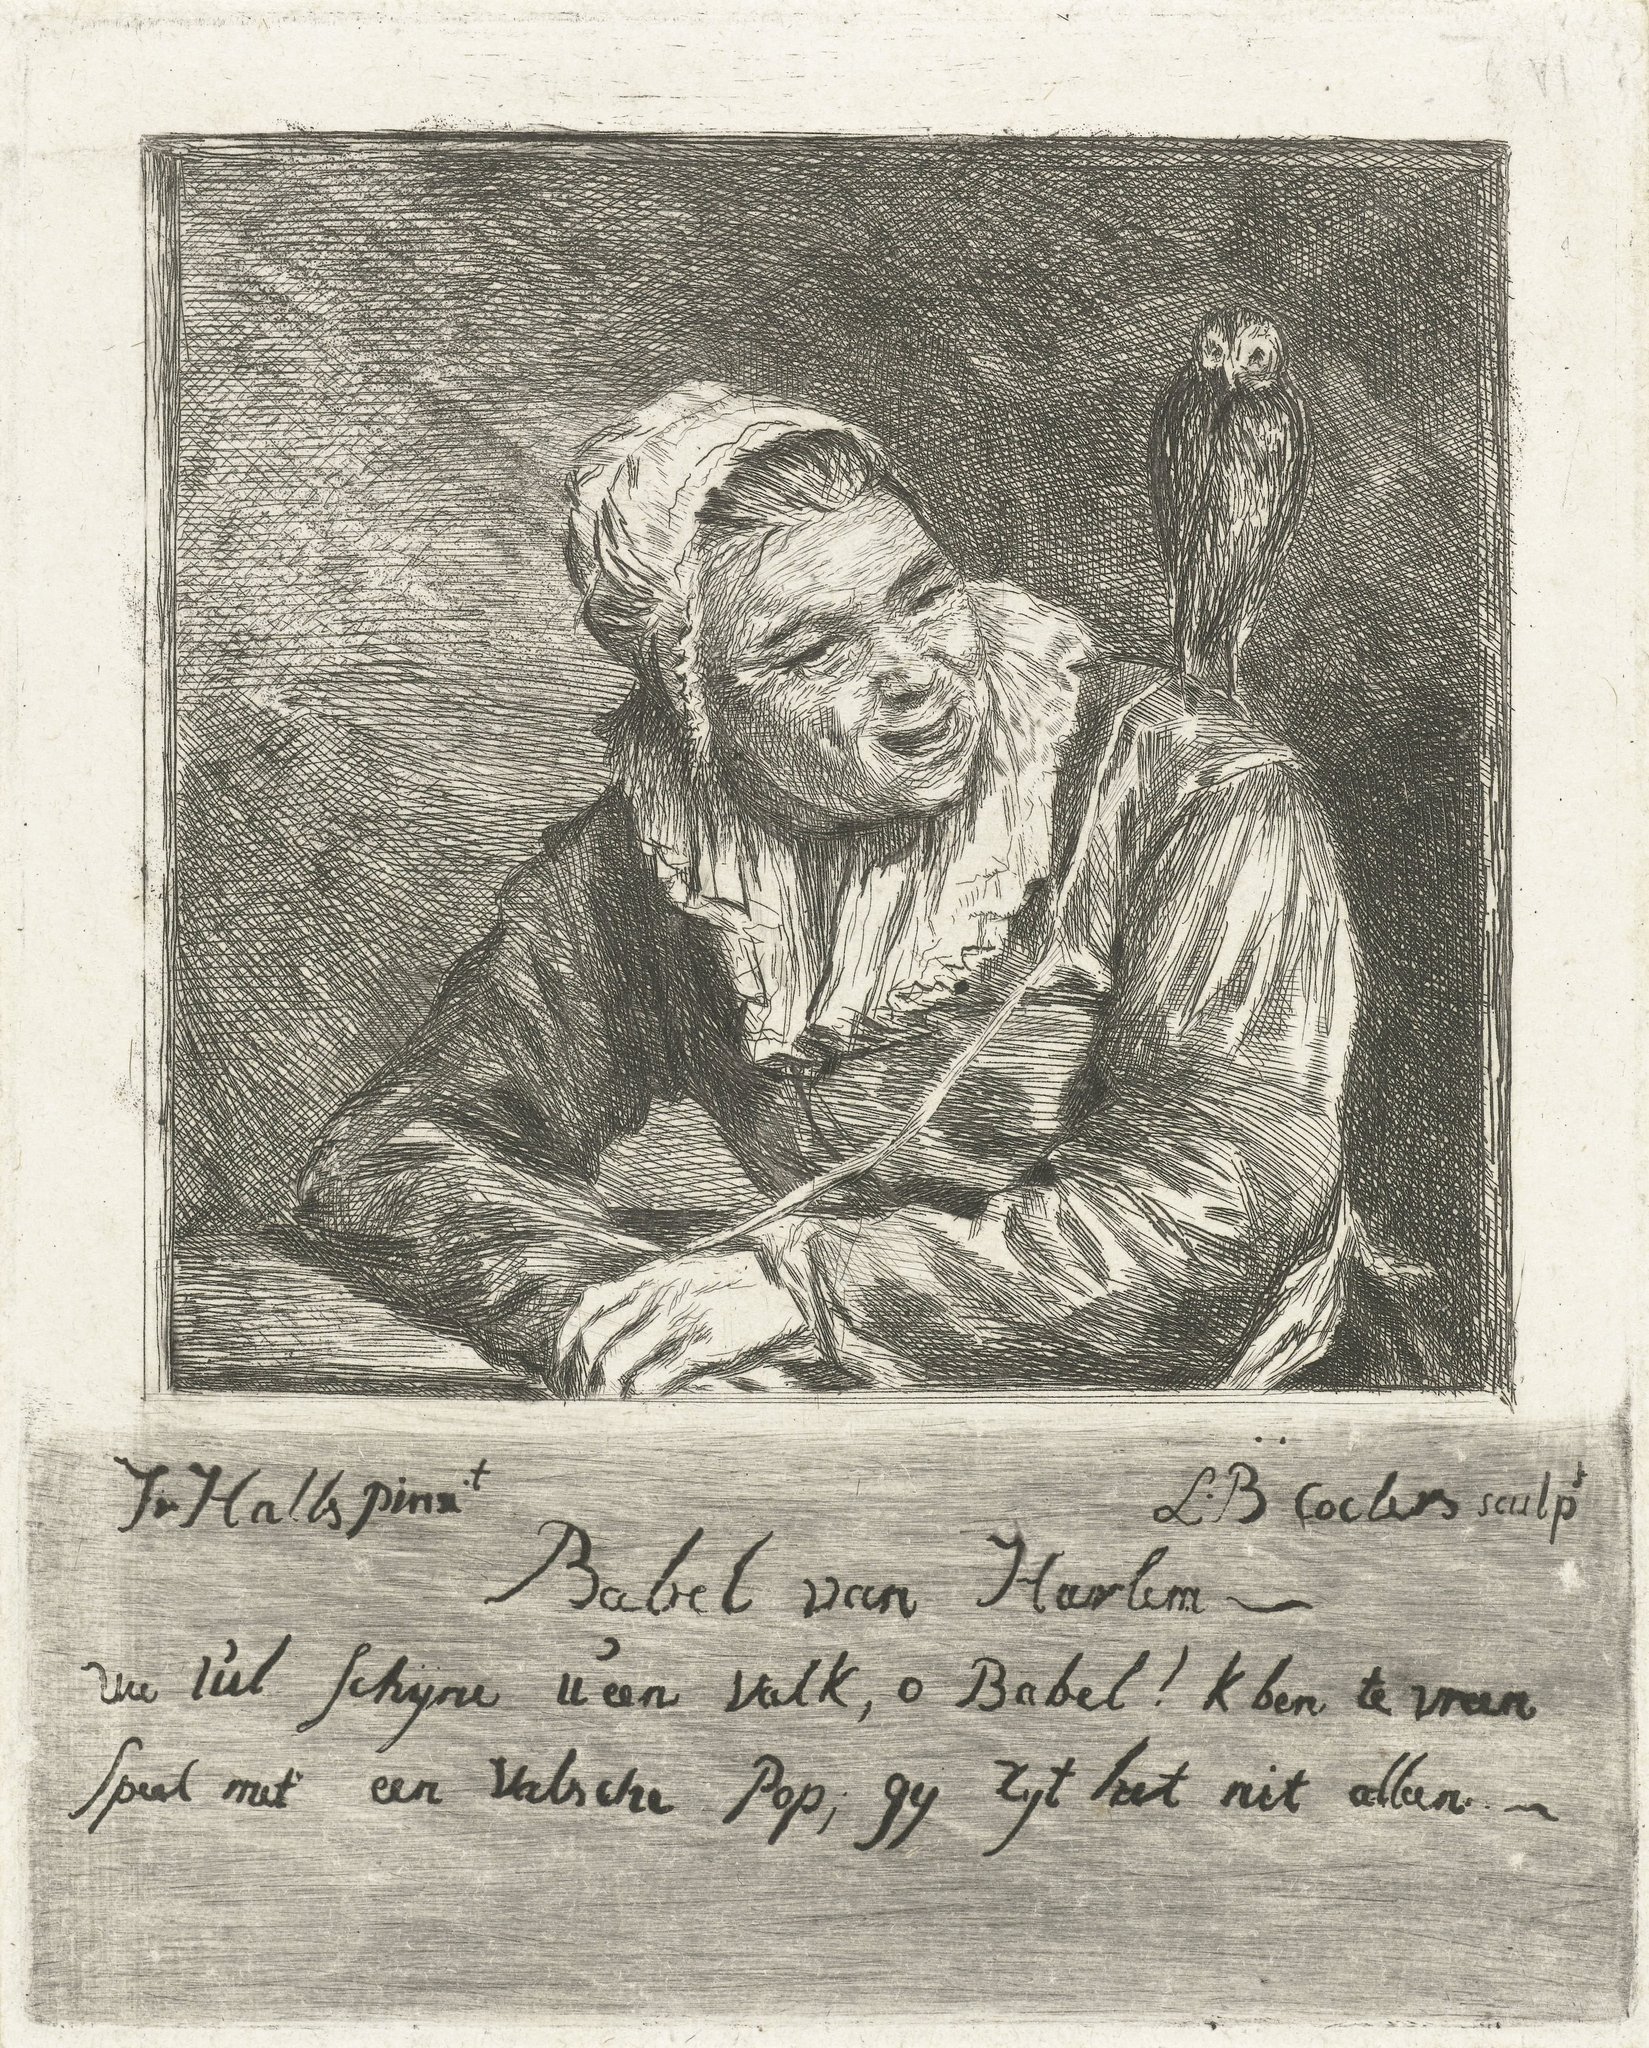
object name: print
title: Malle Babbe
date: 1756-1817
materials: paper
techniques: drypoint, etching, roulette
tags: witch, sorceress, owls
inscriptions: collector's mark: Lugt 2228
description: Portretbuste van een lachende oude vrouw met wit kapje en kraag. Op haar schouder zit een uil. On der de voorstelling een Nederlands vers over de vrouw en de vogel.